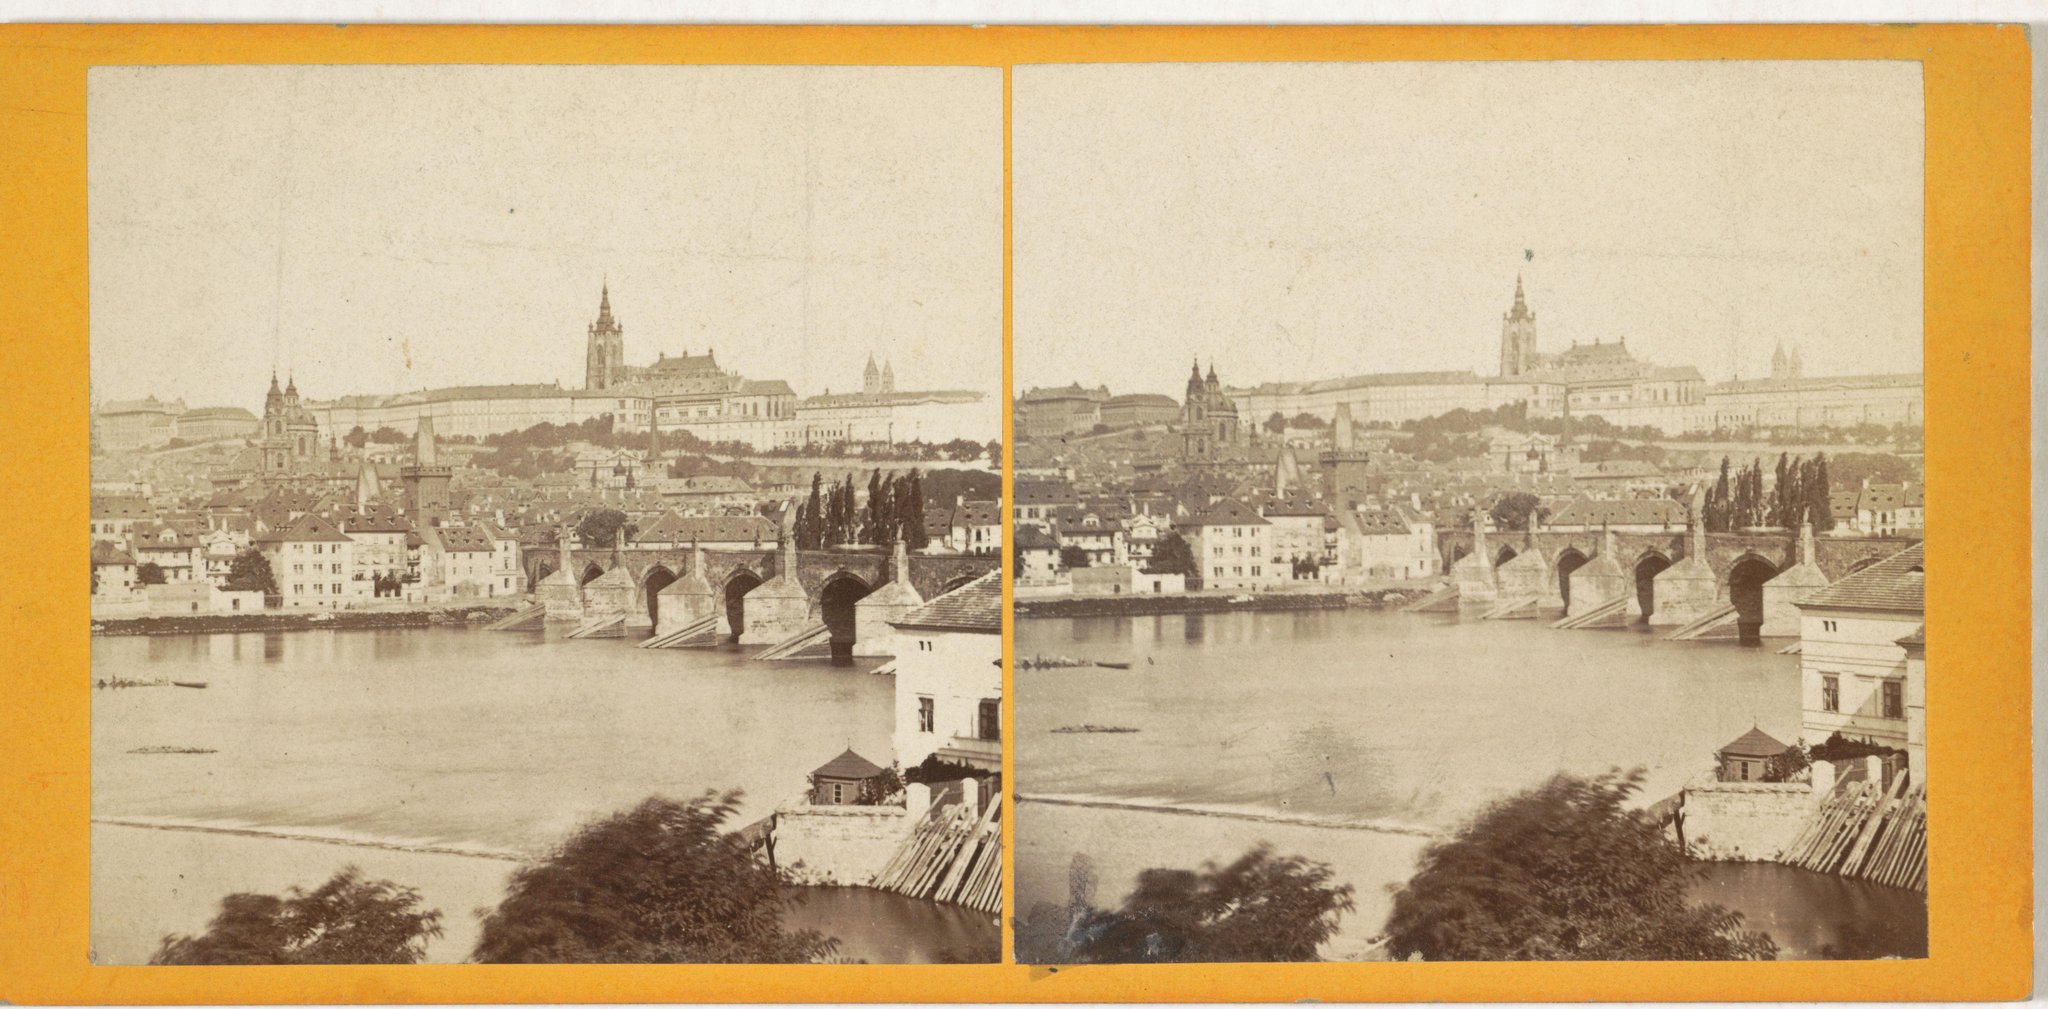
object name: stereograph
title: Hradschin und Kleinseite vom Quai aus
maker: františek fridrich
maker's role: publisher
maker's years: 1829-1892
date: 1855-1868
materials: cardboard, paper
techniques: albumen print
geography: prague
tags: city-view in general; 'veduta', prague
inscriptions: inscription: ‘K. Pr. Hoffotograf’, inscription: ‘4322 [...]’, number: ‘98’, retailer's mark: ‘Zur Stadt Paris 596/ 1’